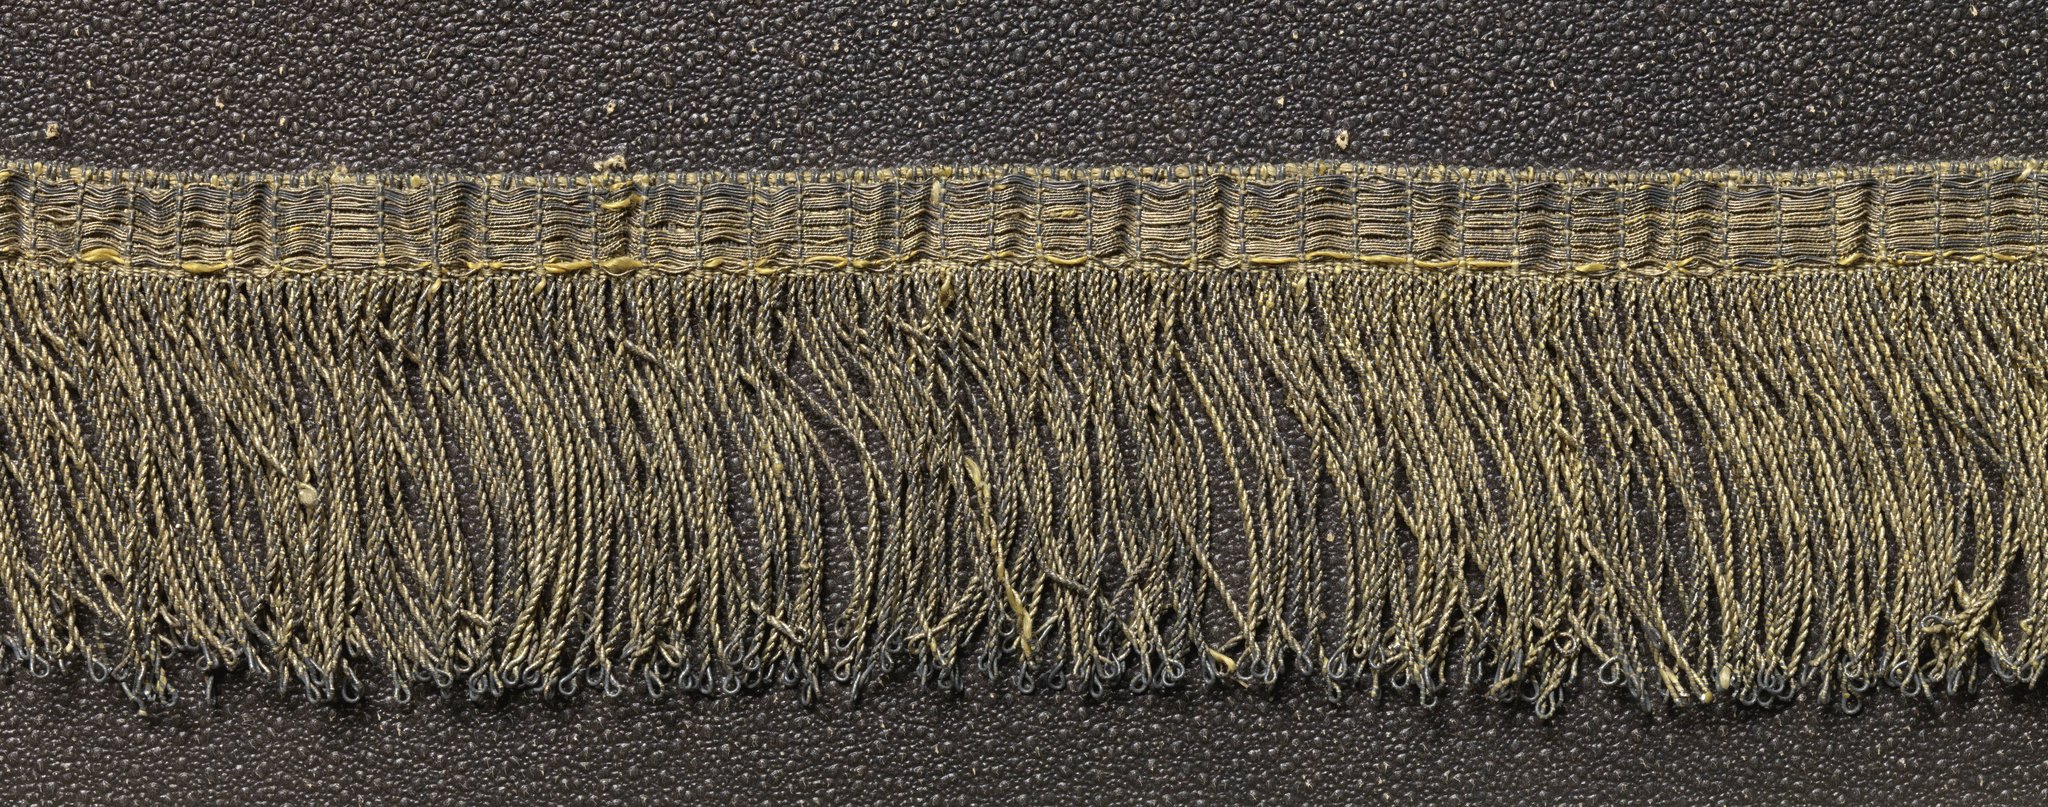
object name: fringe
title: Franje van goud en rode zijde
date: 1700-1900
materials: gold thread, silk